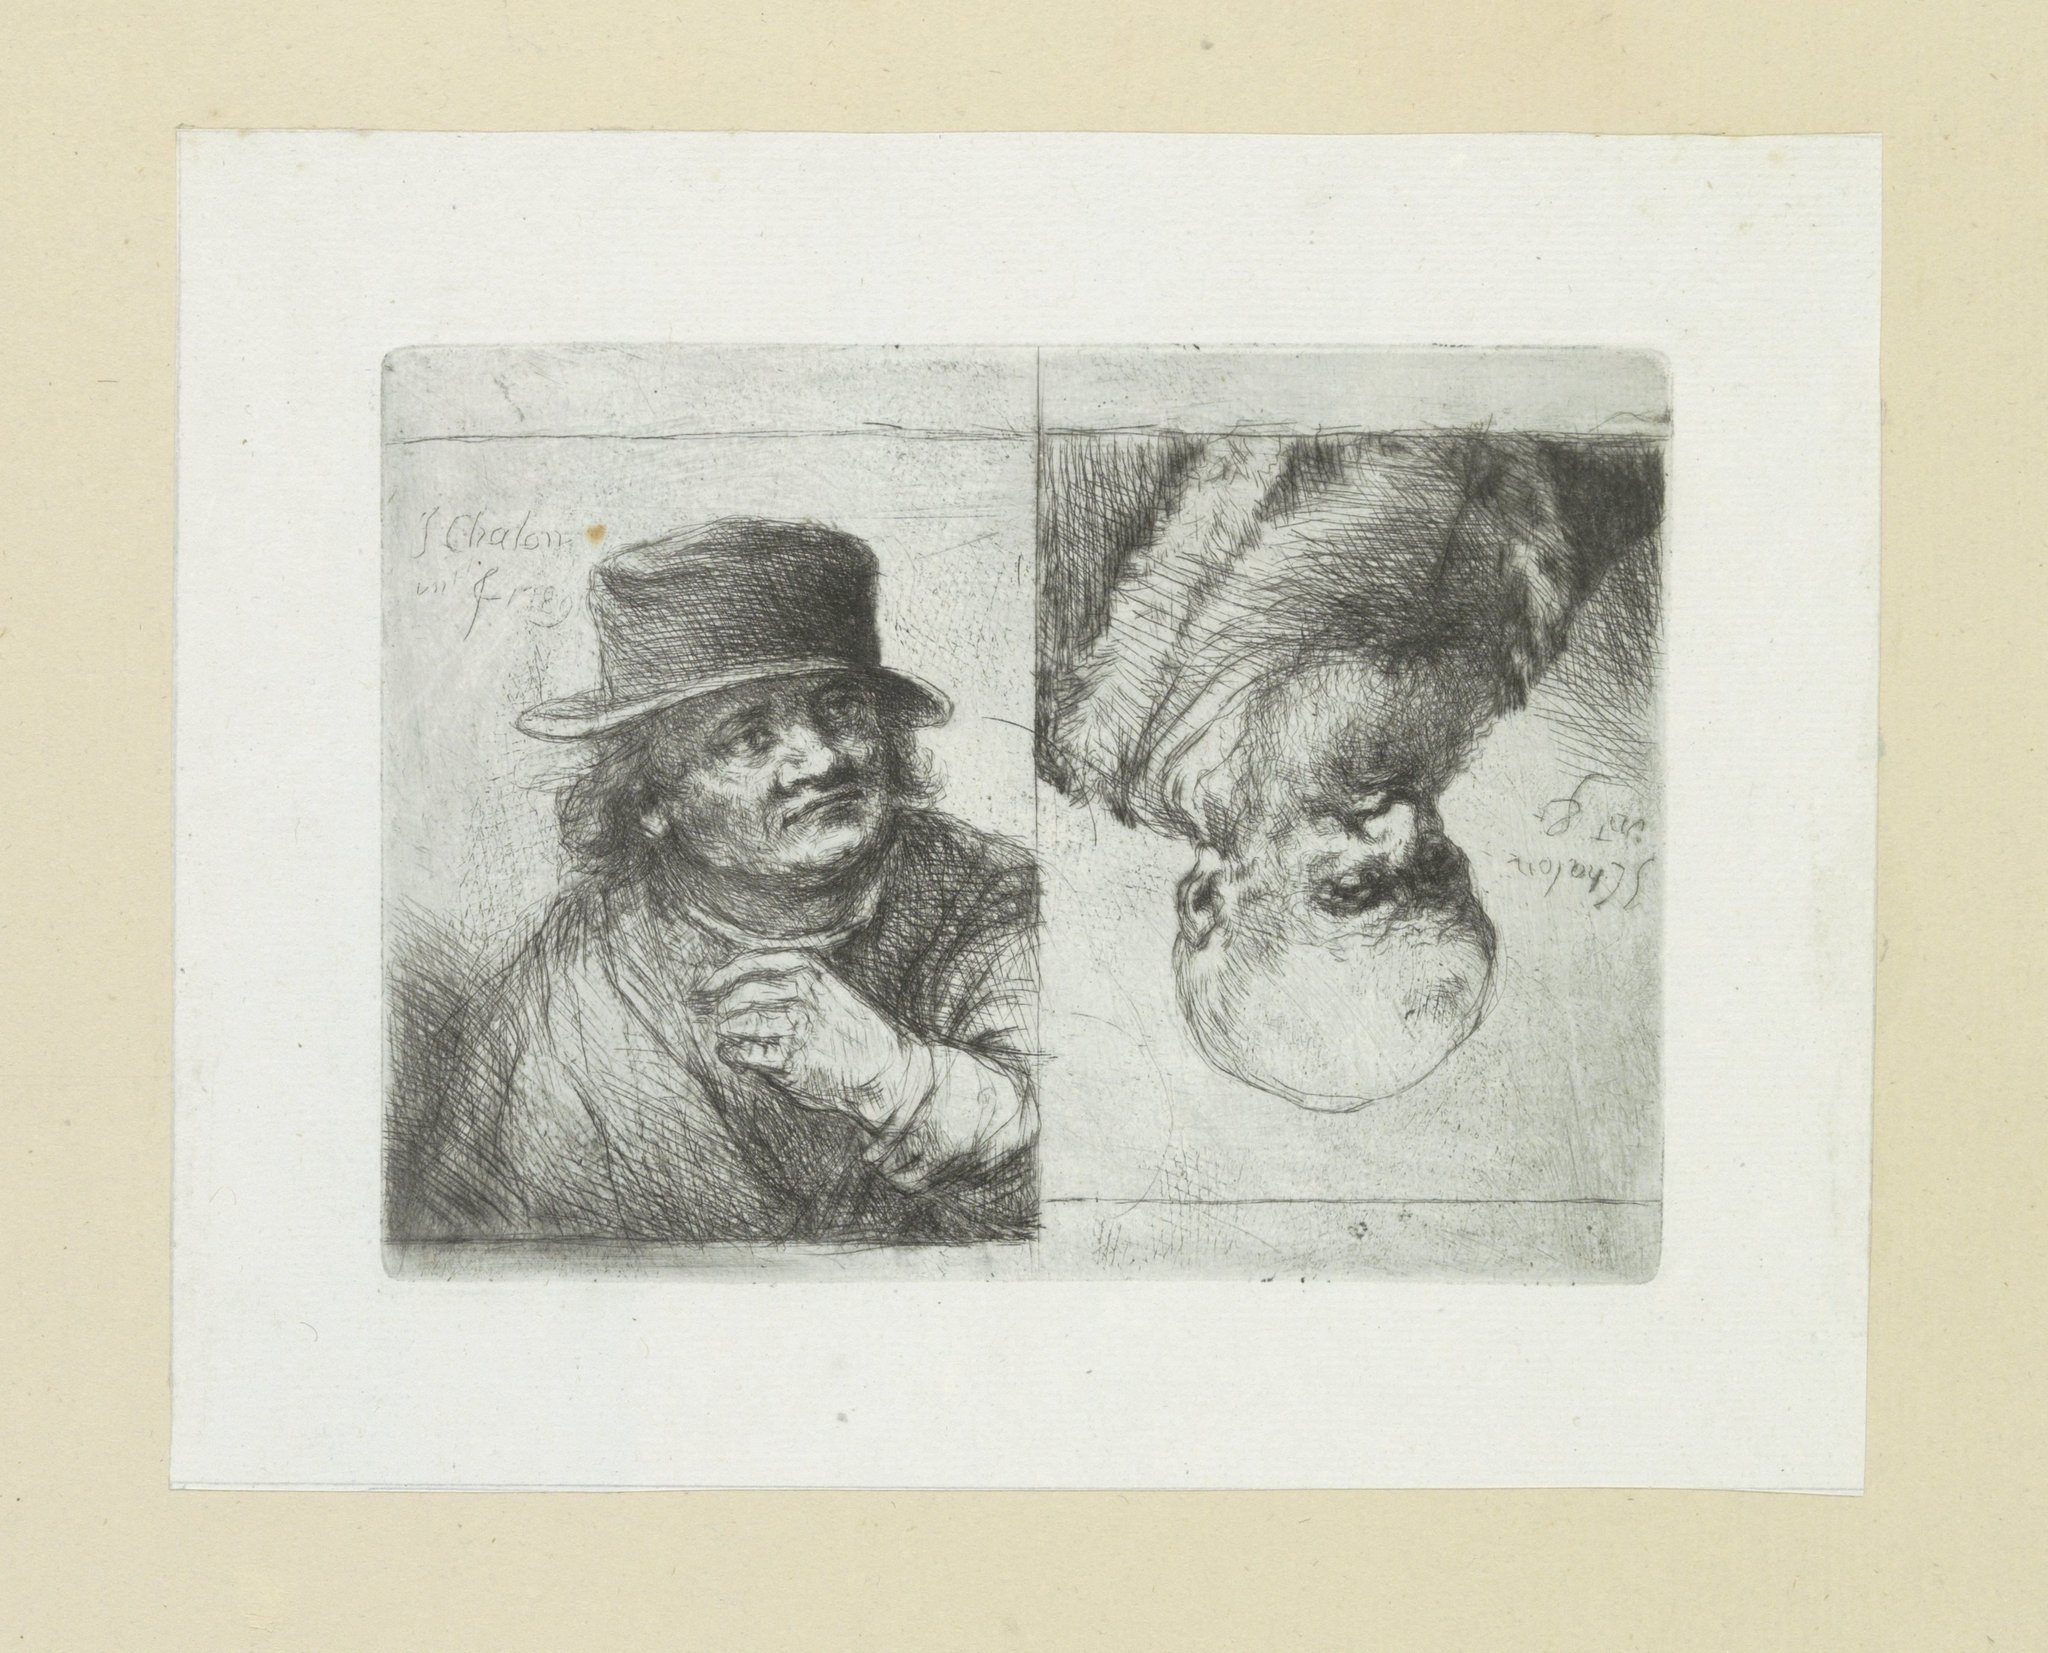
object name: print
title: Twee mansportretten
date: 1789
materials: paper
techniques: drypoint, etching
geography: london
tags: morphology of human expression (+ old male (human being)), morphology of human expression (+ adult male (human being))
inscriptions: collector's mark: ‘RIJKS / MUSM’, collector's mark: ‘B’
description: Twee portretten op een onversneden blad. Links een man met een hoed, naar rechts. Rechts een oude man met een baard en een pelsmantel, naar links. De prent maakt deel uit van een album.